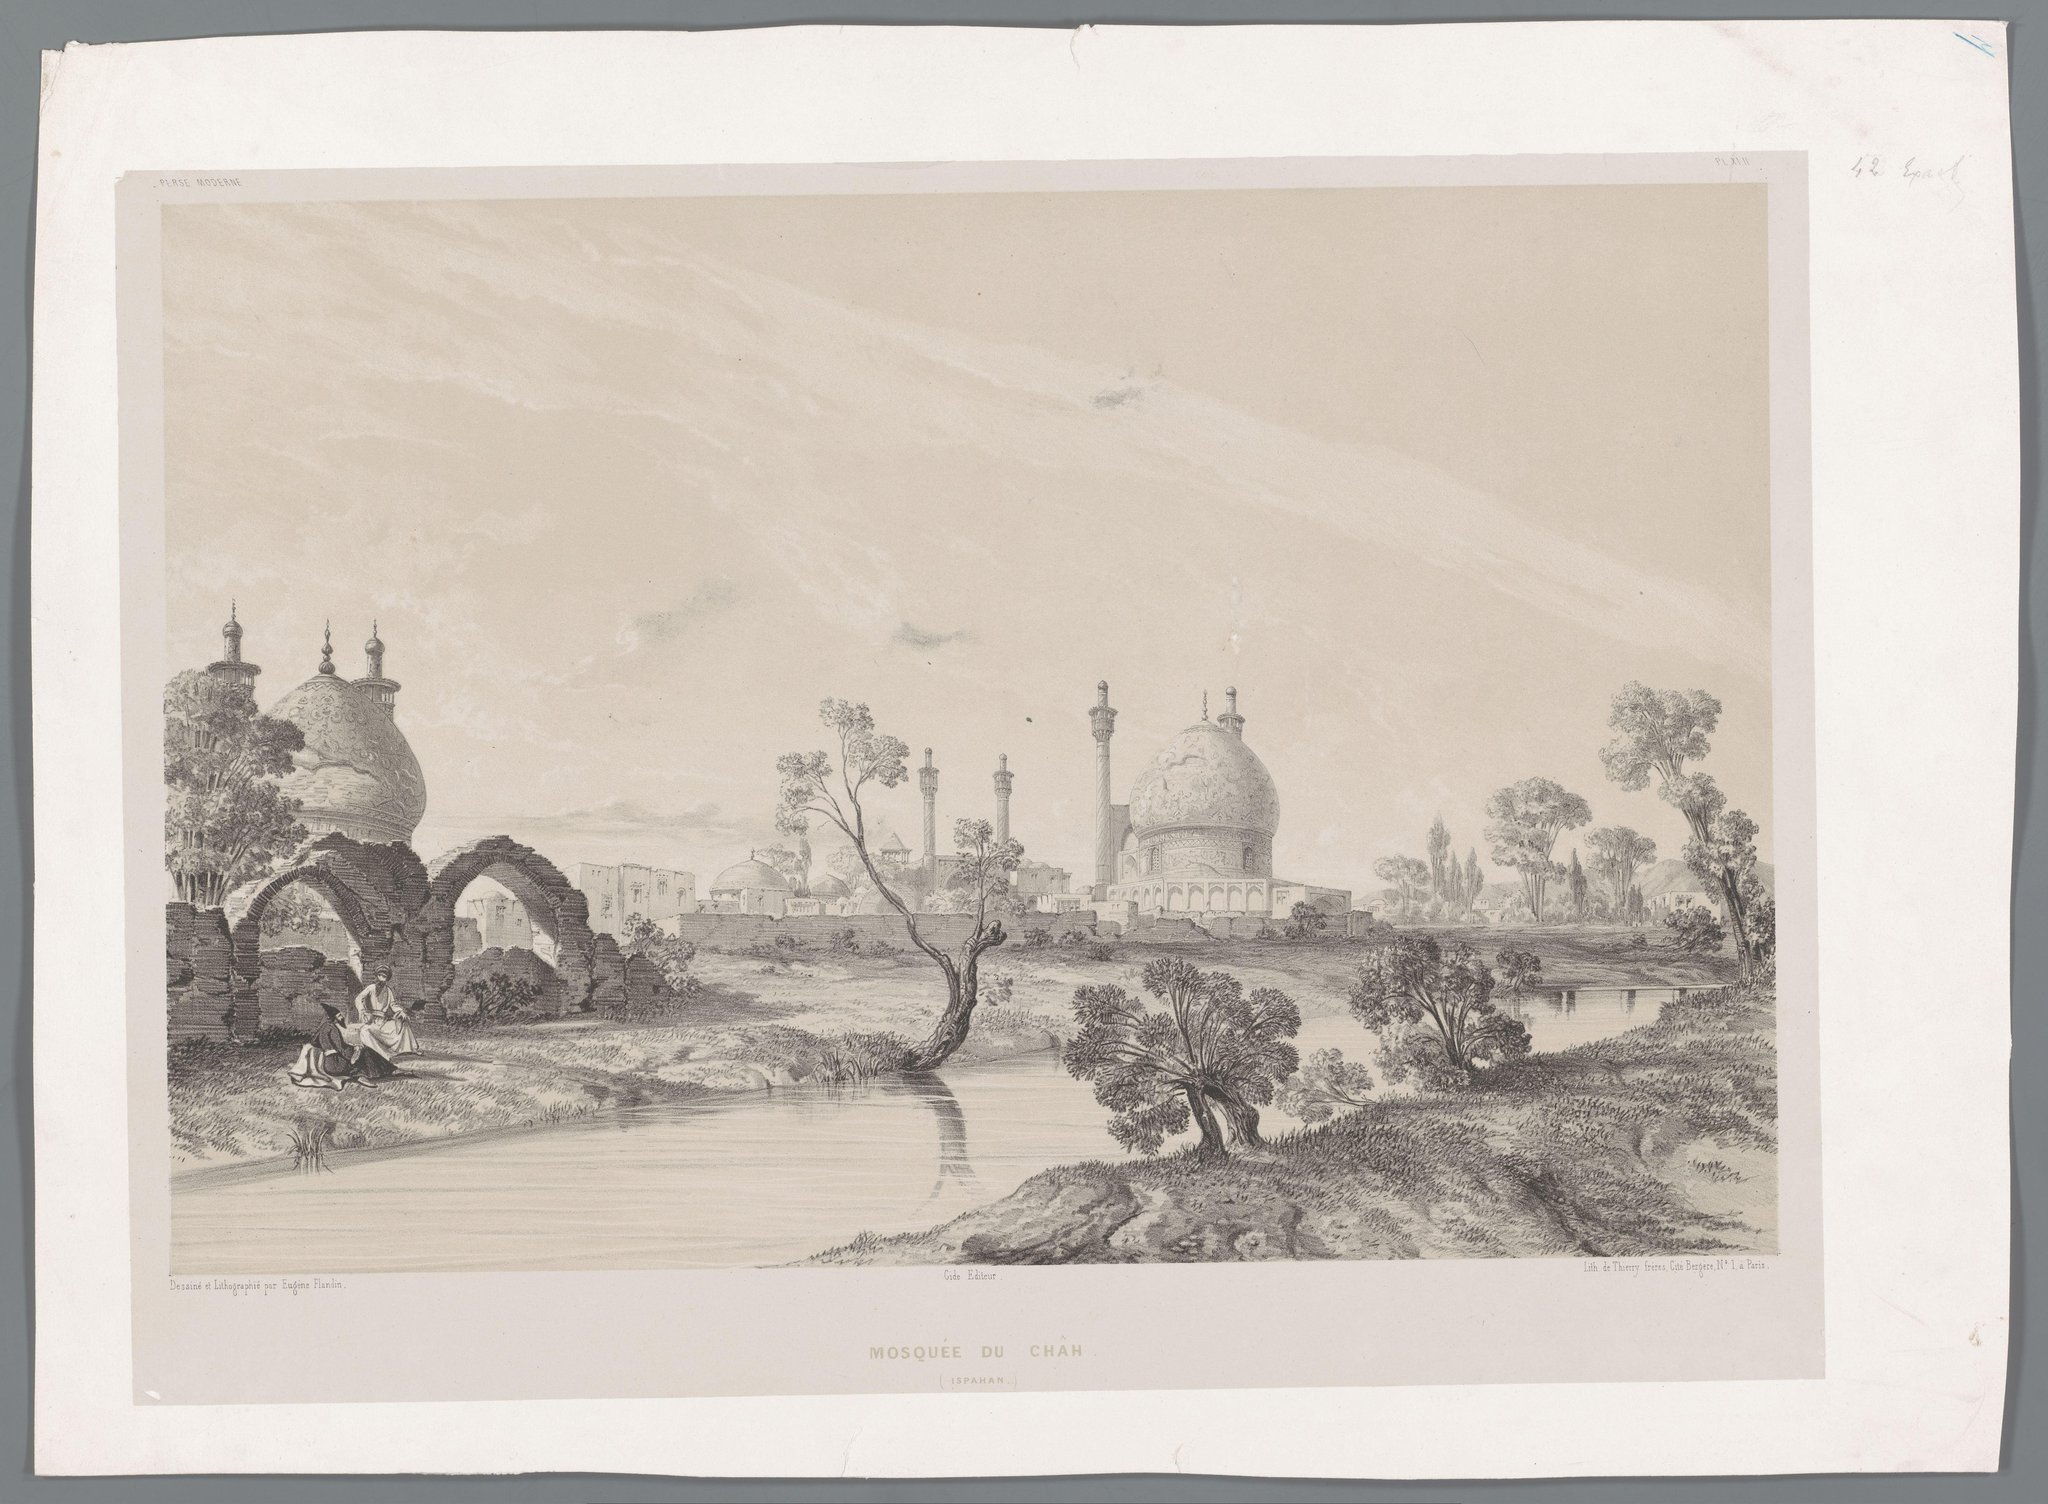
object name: print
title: Perzische landschappen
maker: eugène flandin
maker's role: painter, print maker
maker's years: 1809-1889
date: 1843-1854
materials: paper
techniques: tone lithography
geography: paris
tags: temple, shrine ~ islam, mohammedanism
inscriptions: collector's mark: Lugt 2760, collector's mark: Lugt 2228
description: Prent uit: Coste, Pascal-Xavier en Eugène Napoléon Flandin. Voyage en Perse de mm. Eugène Flandin, peintre, et Pascal Coste, architecte (...). 8 dln. Parijs: Gide et Jules Baudry, 1843-1854.